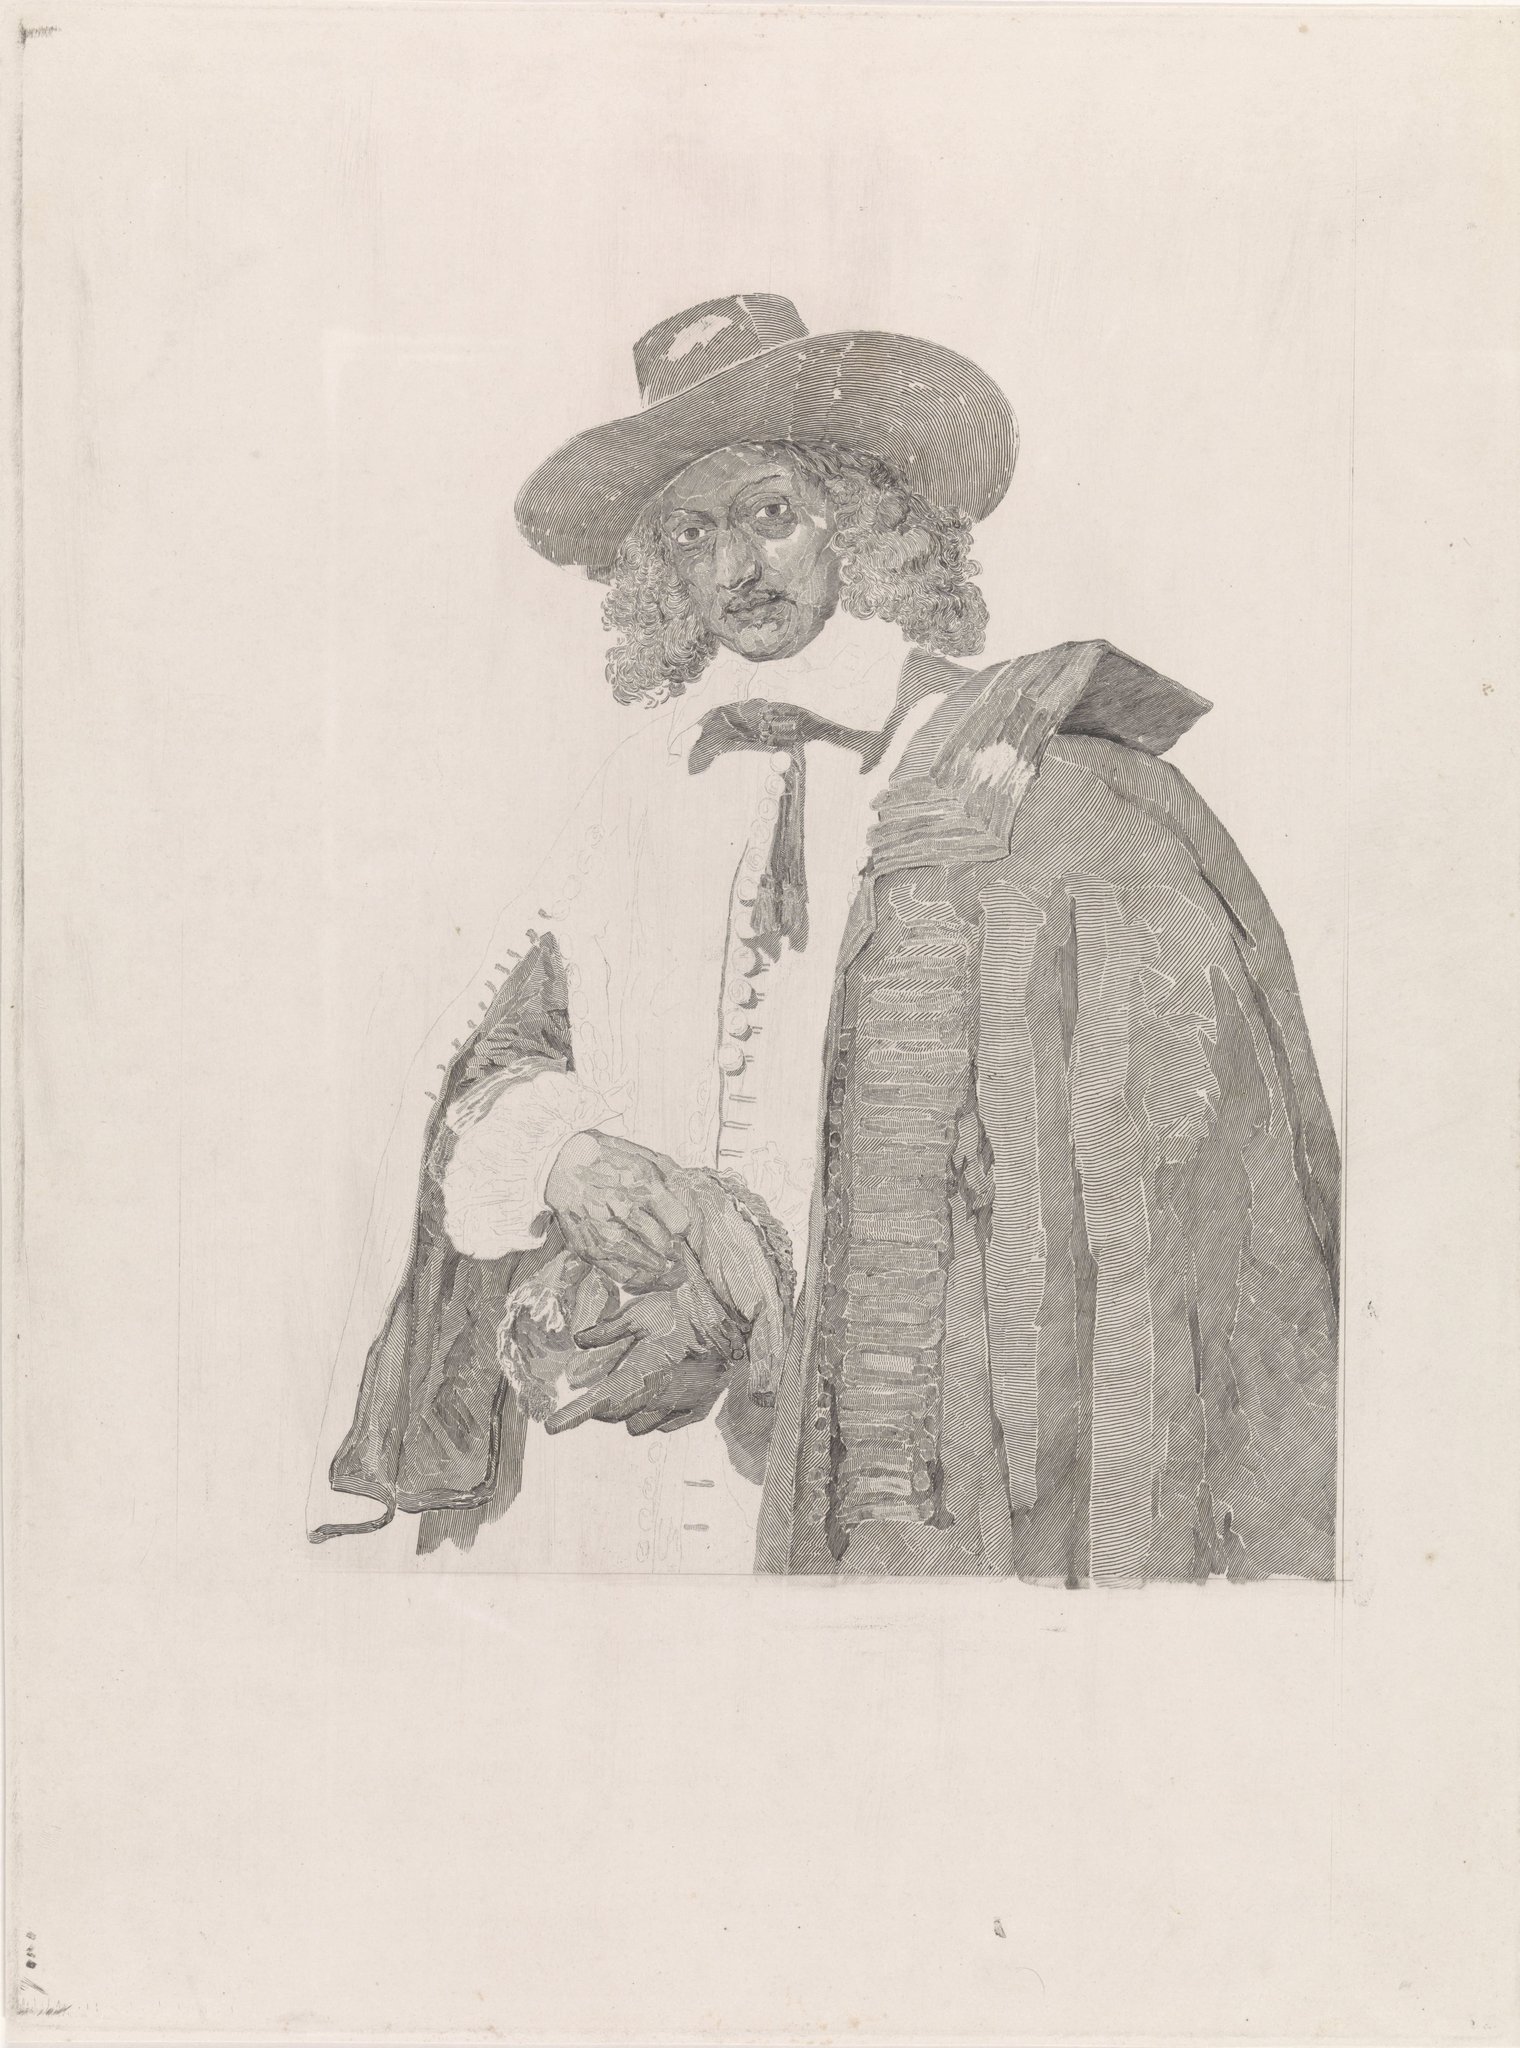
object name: print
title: Portret van Jan Six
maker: johann wilhelm kaiser (i)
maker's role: draughtsman, print maker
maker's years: 1813-1900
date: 1823-1853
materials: paper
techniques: etching, roulette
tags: mayor, jan six (1618-1700)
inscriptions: collector's mark: Lugt 2228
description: Portret ten halven lijve van Jan Six, burgemeester van Amsterdam.